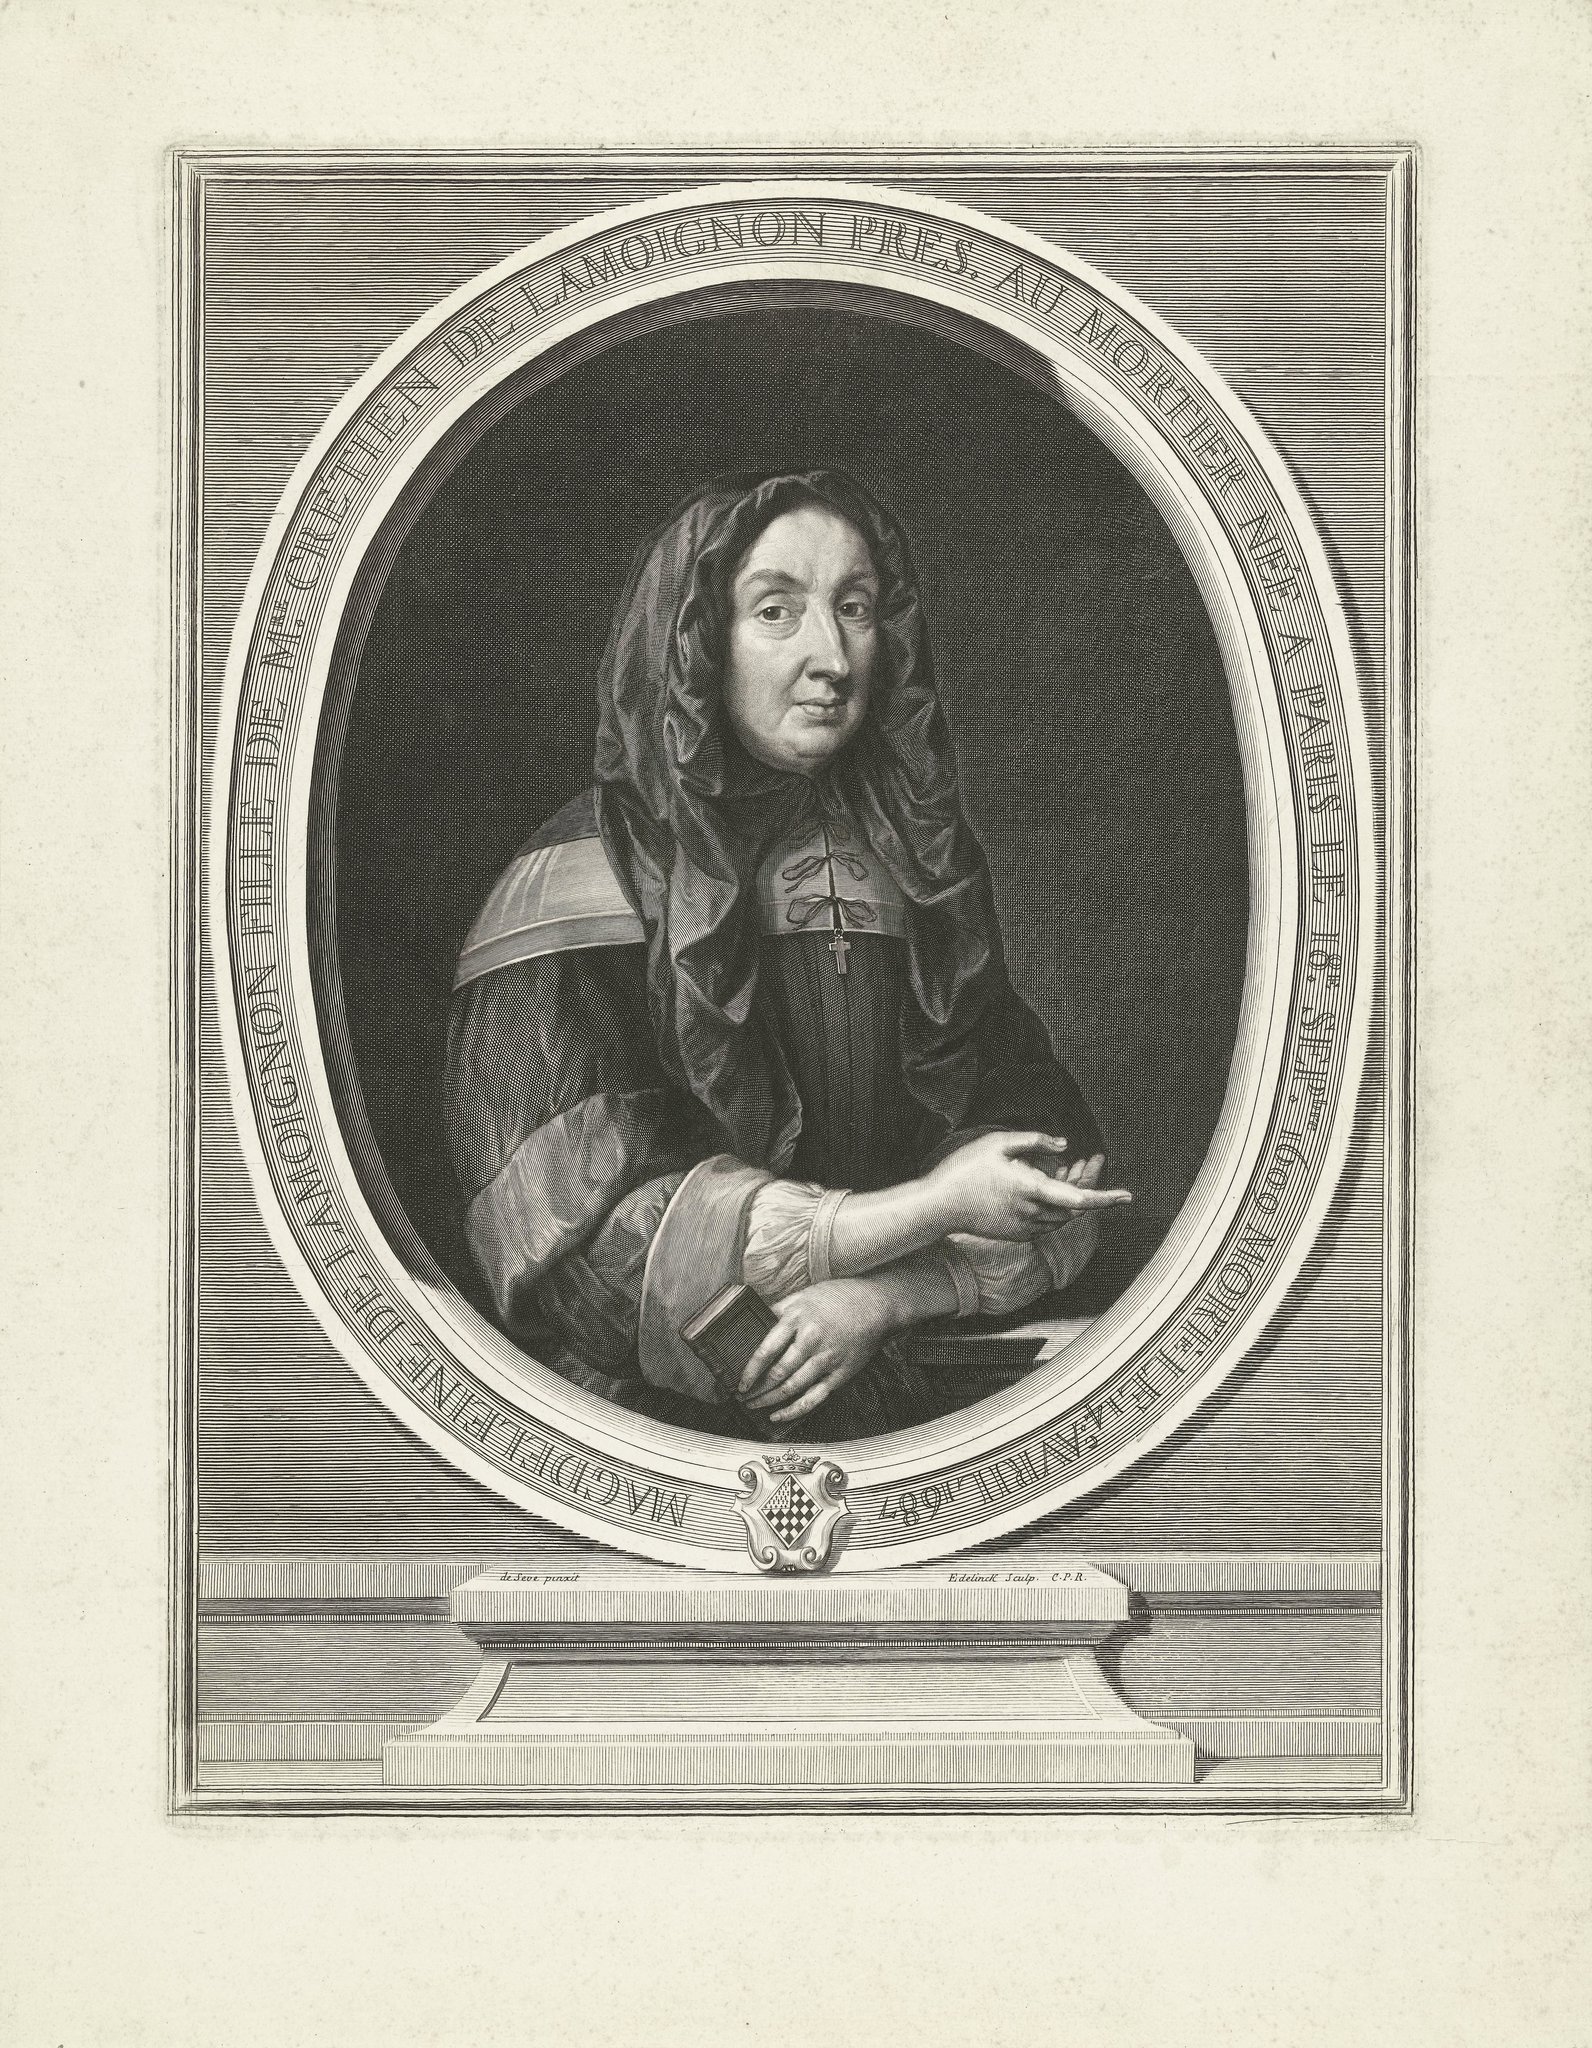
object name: print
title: Portret van Madeleine de Lamoignon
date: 1687-1707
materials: paper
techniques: engraving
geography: paris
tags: madeleine de lamoignon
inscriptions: collector's mark: Lugt 240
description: Portret van Madeleine de Lamoignon (1609-1687) met hoofddoek en boek in haar linker hand. Afgebeeld in ovale omlijsting met tekst en wapen, waaronder een console.